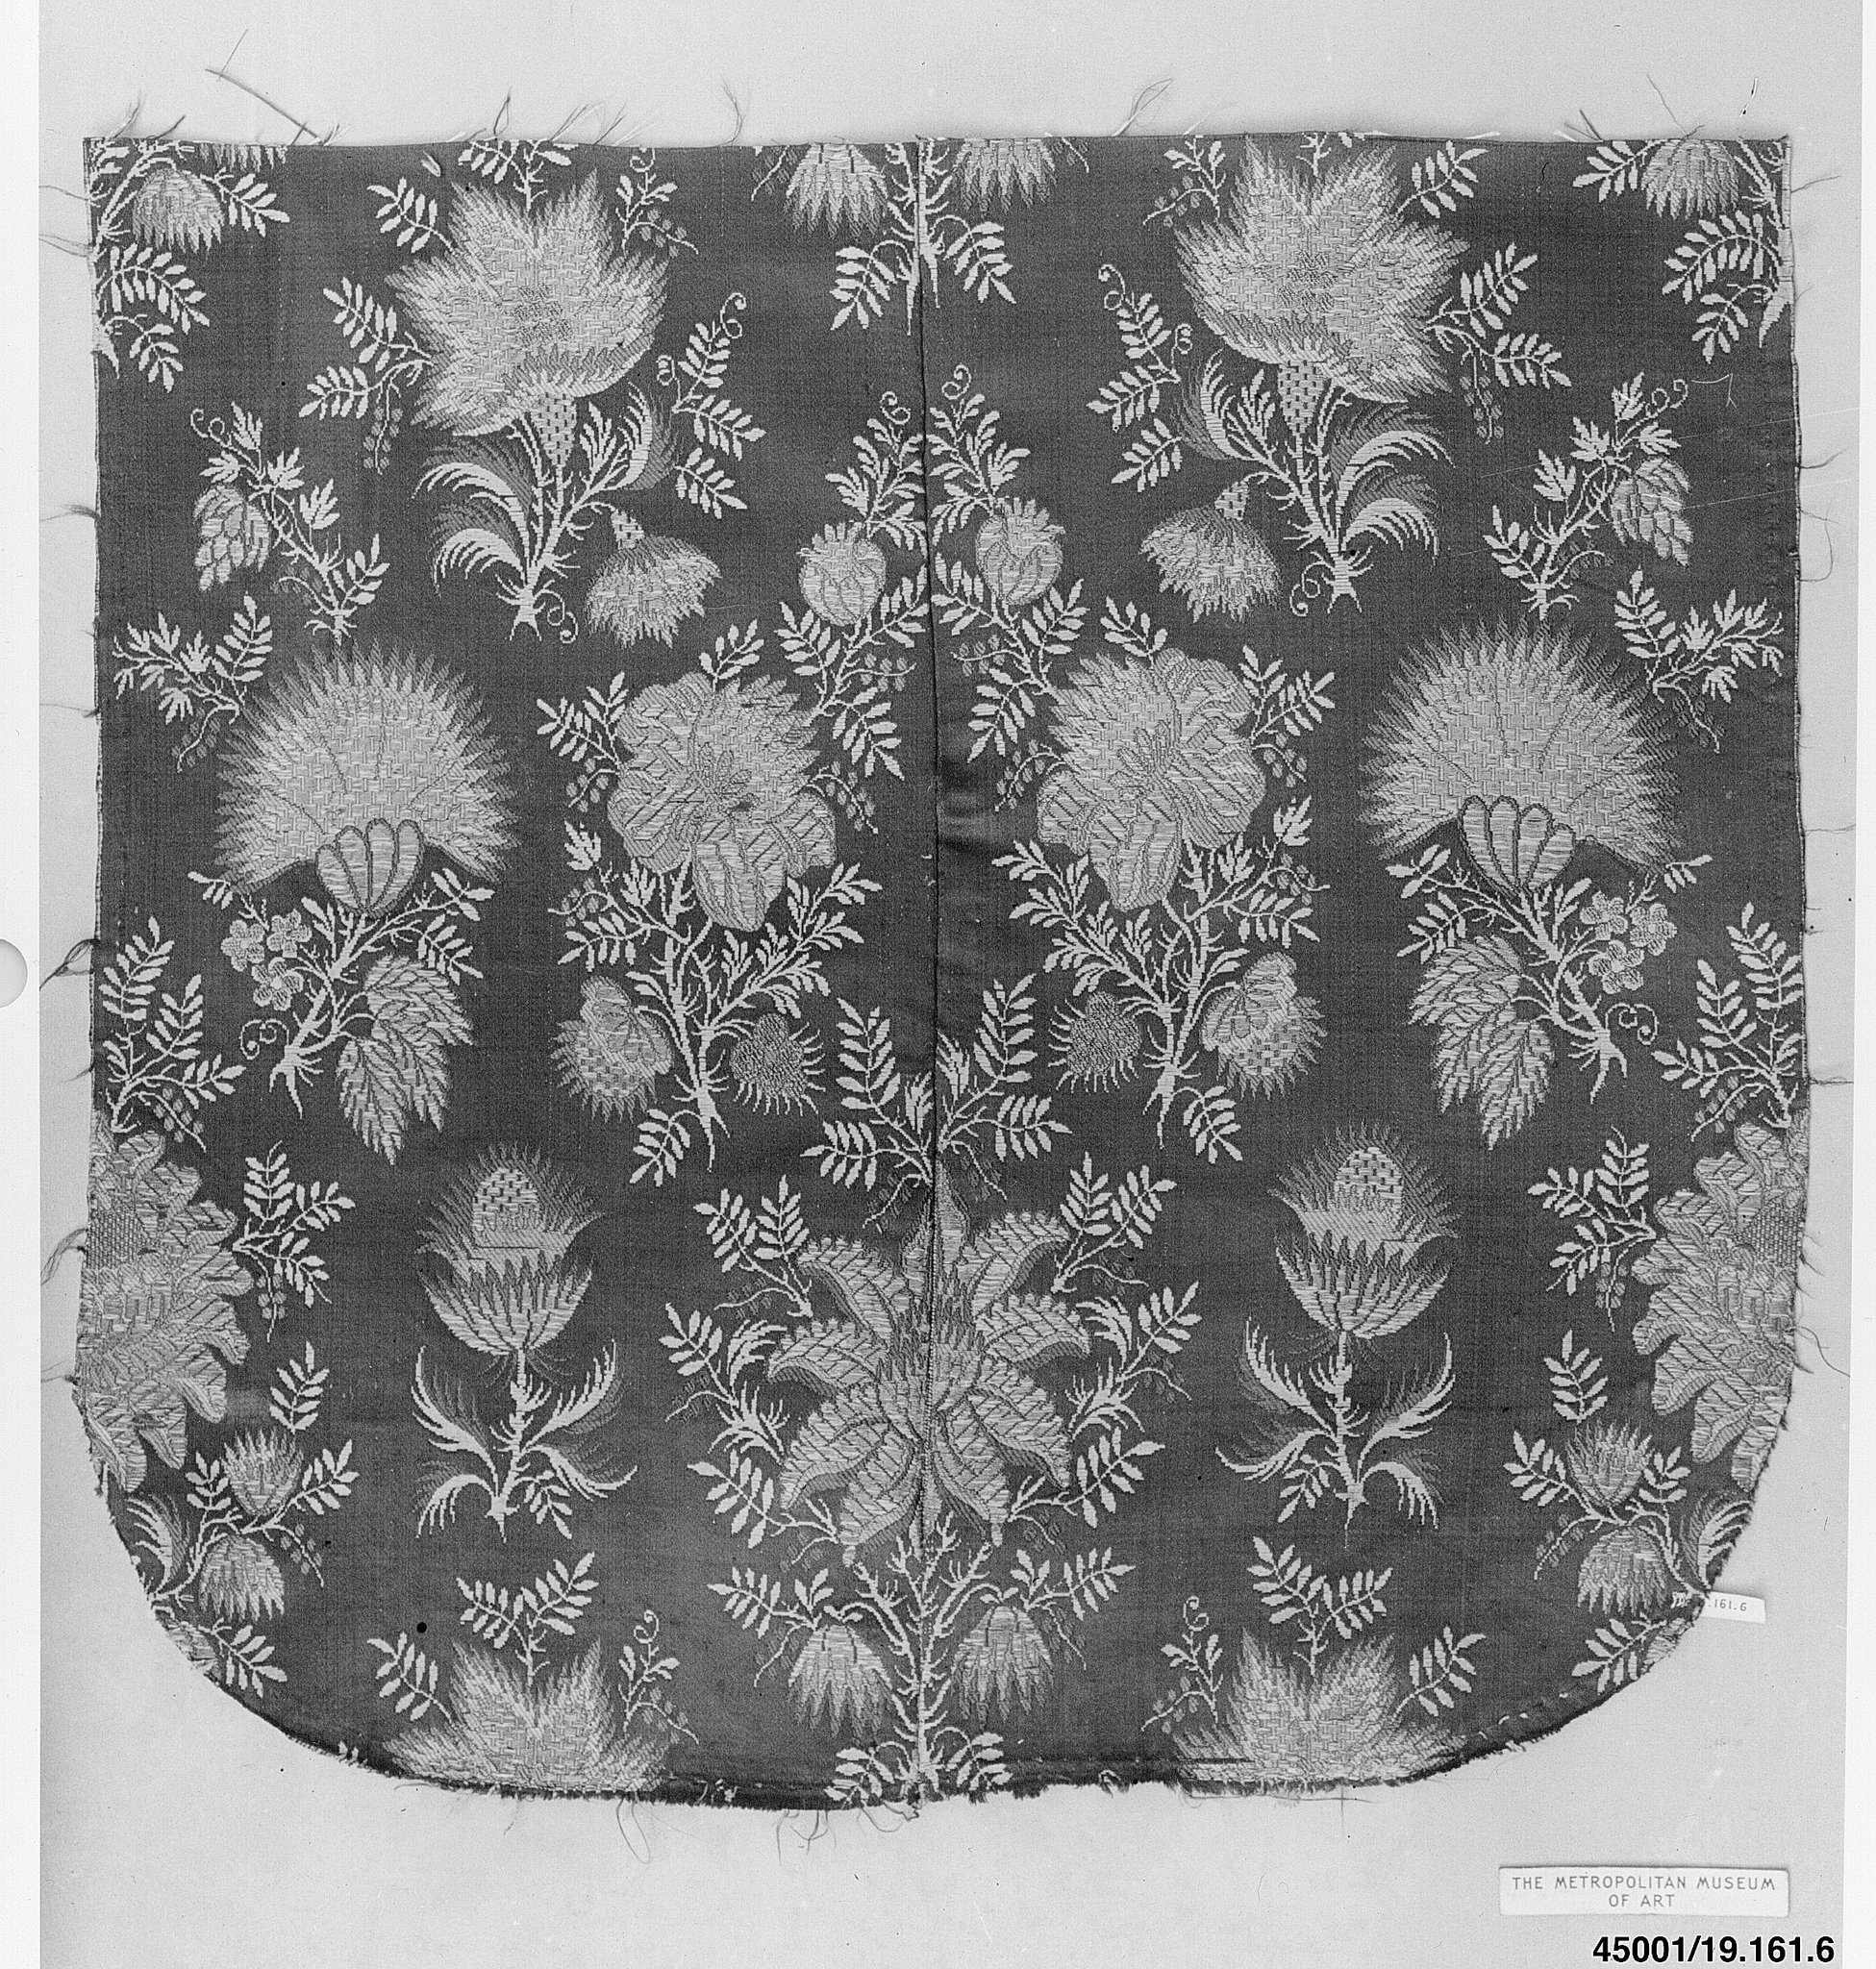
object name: fragment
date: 1730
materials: metal thread, silk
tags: flowers,leaves